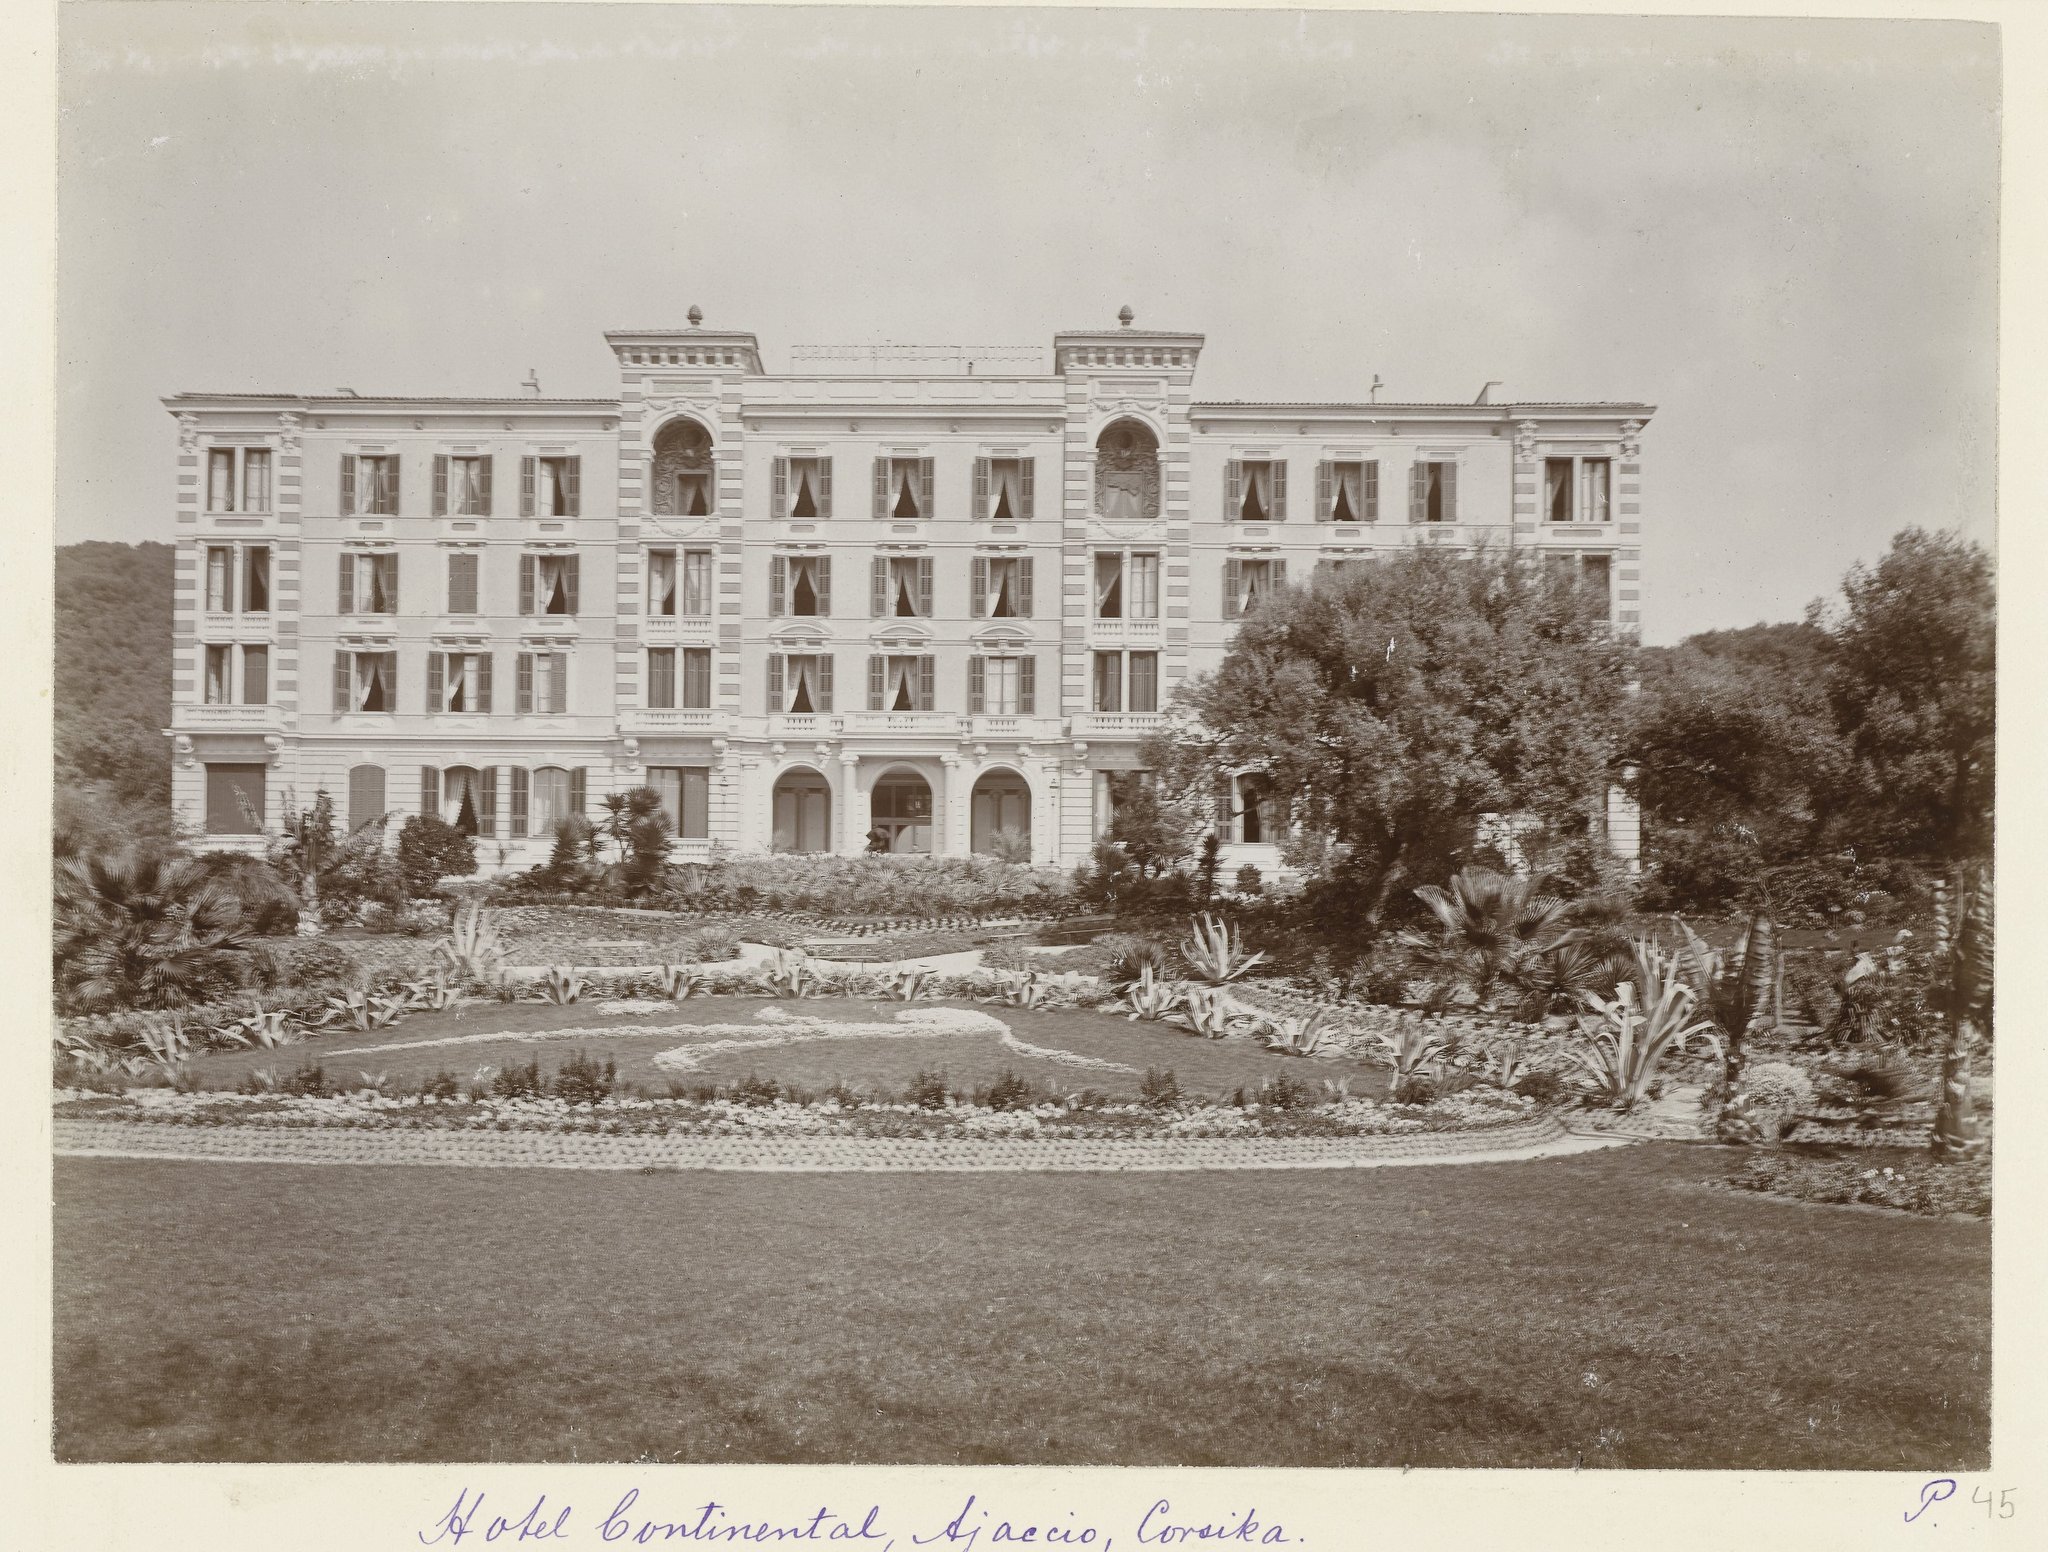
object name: photograph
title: Hotel Continental, Ajaccio, Corsika.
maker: henry pauw van wieldrecht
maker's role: fotograaf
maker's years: 1863-1912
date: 1886-1896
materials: cardboard, photographic support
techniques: albumen print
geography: corsica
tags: ajaccio